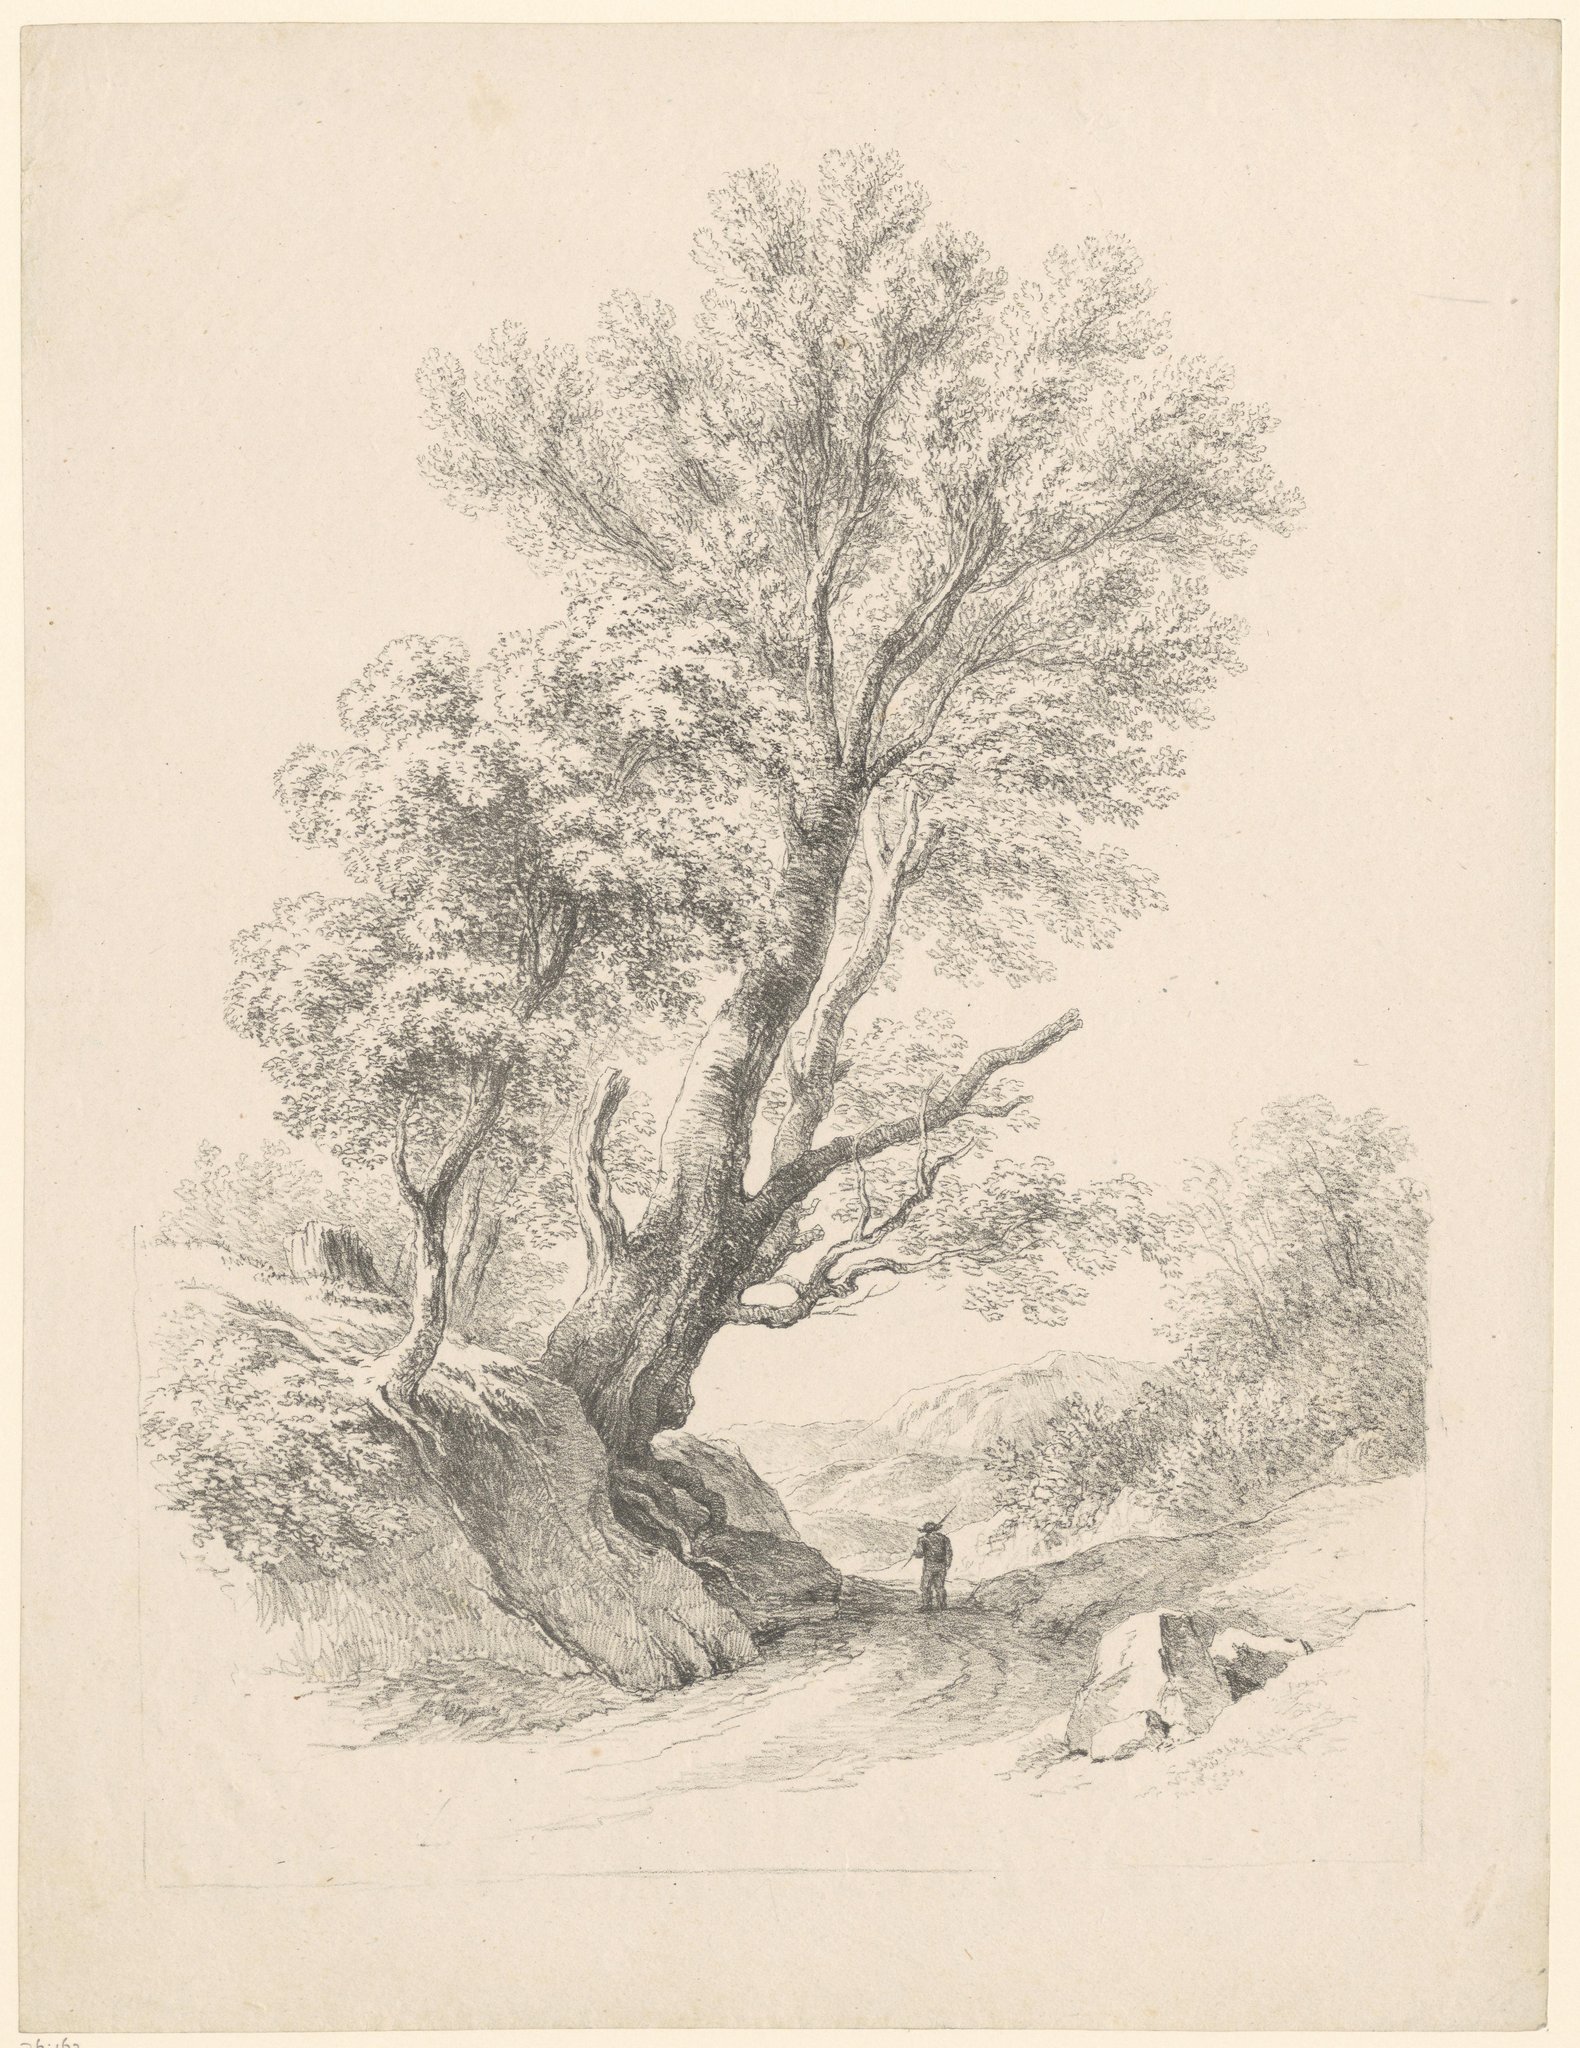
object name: print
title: Landschappen door Joseph Mössmer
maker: joseph mössmer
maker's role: print maker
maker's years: 1780-1845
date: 1818-1821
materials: paper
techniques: lithograph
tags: trees, road, path, landscapes in the temperate zone (+ landscape with figures, staffage)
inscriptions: collector's mark: Lugt 2760, collector's mark: Lugt 2228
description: Deze prent behoort waarschijnlijk tot een serie met zeventien landschappen door Joseph Mössmer uit ca. 1818-1821. Mogelijk is dit de twaalfde prent in de serie.